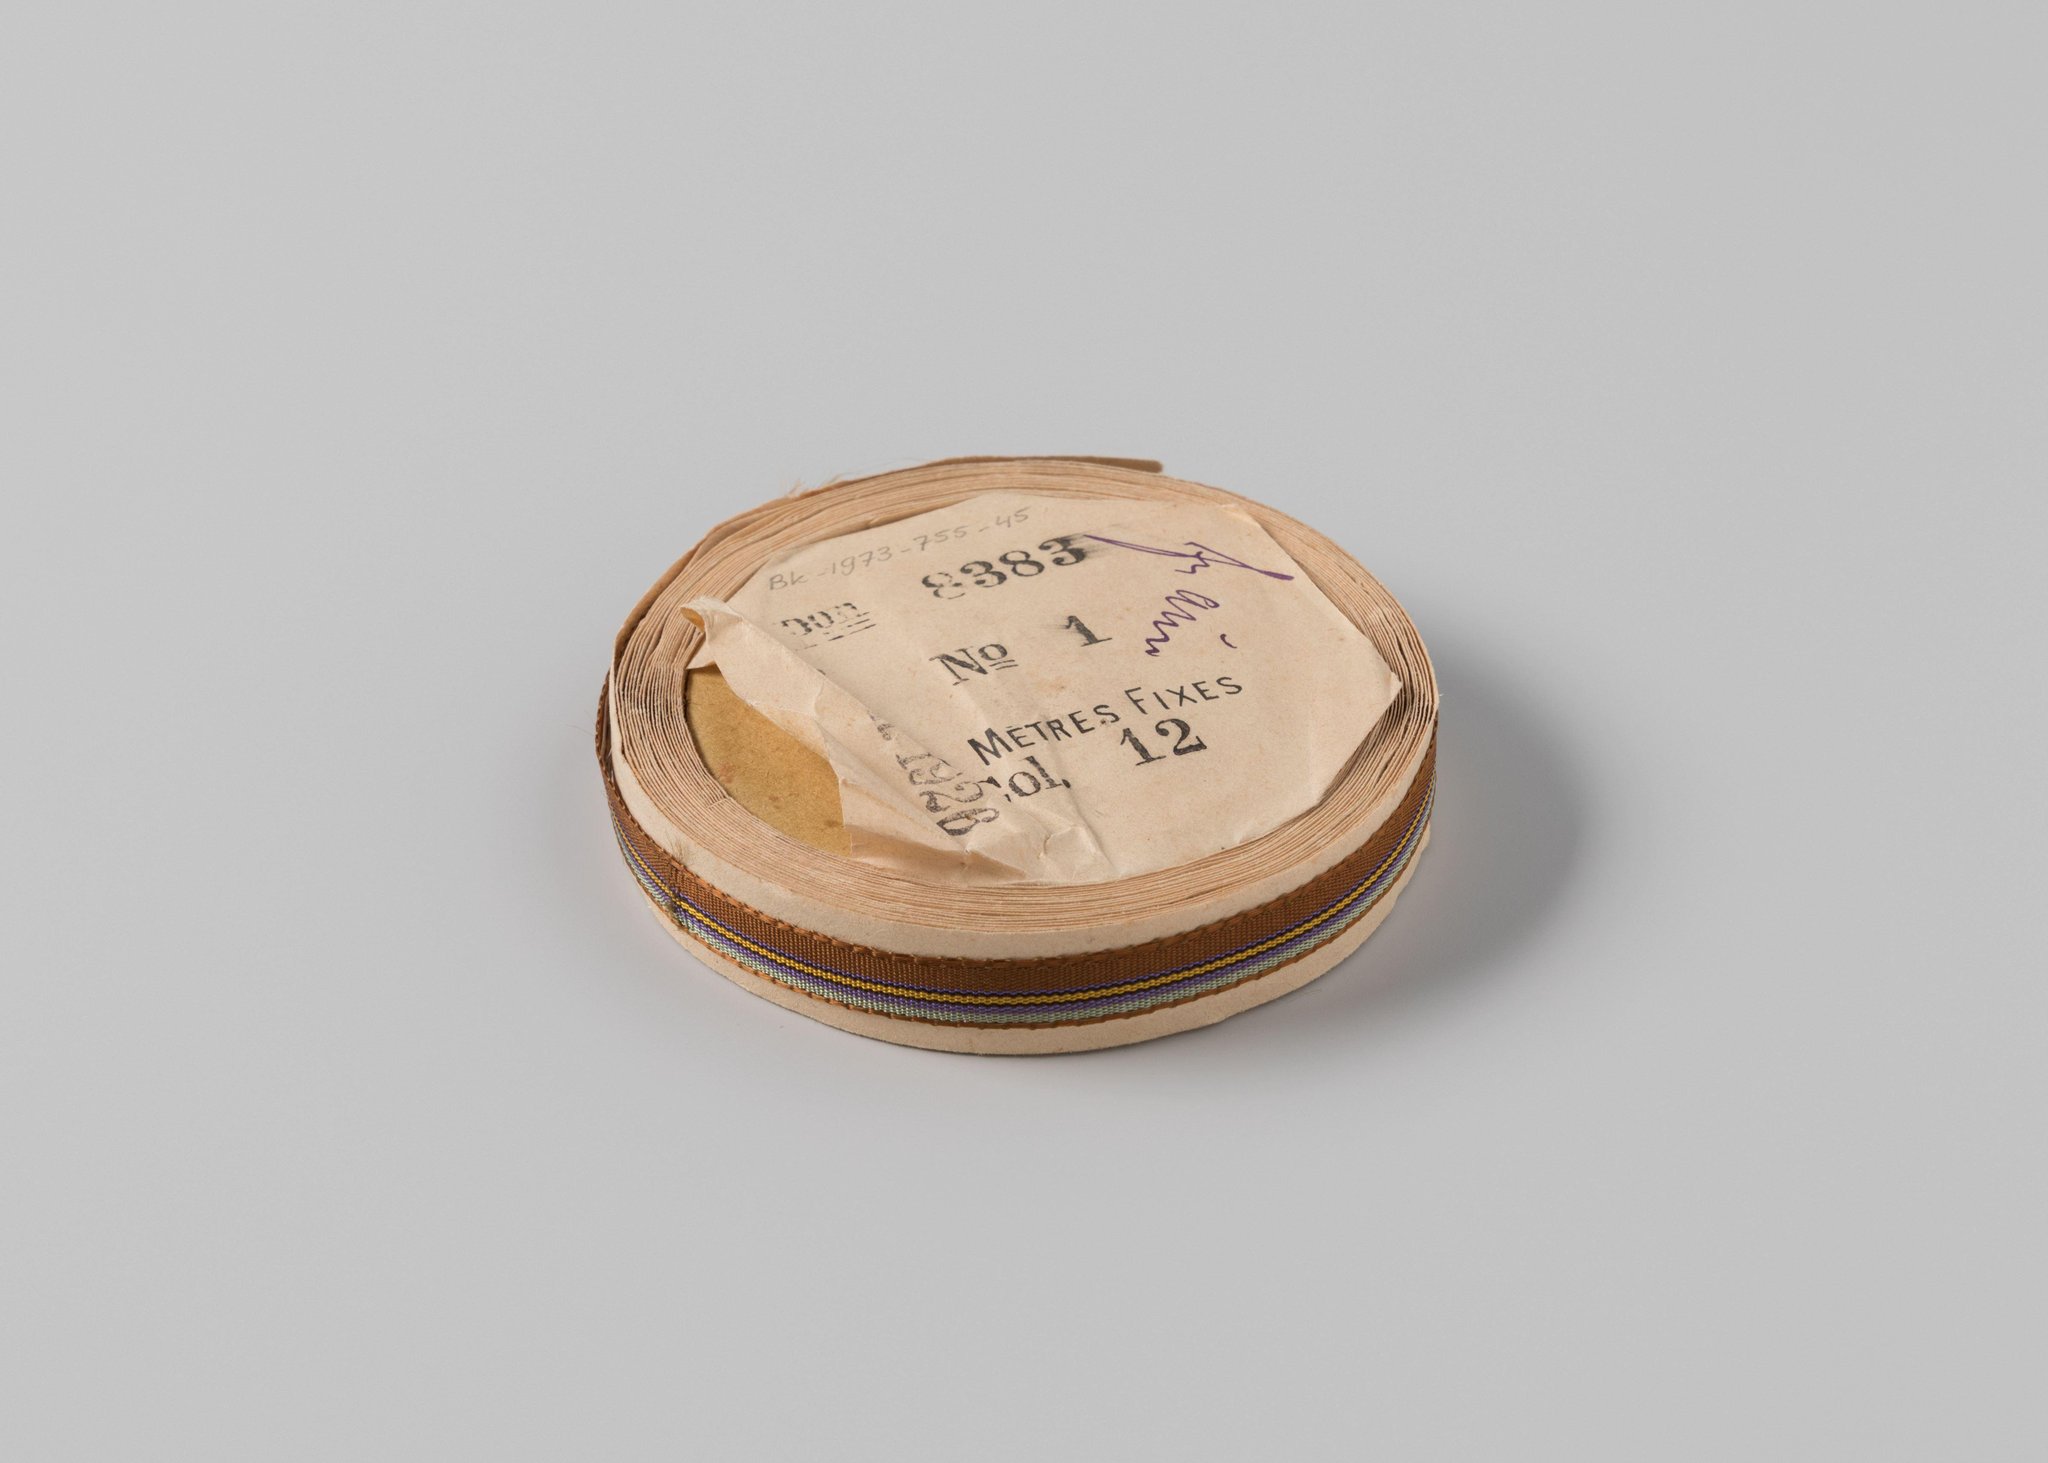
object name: ribbon material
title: Lint op rol, gestreept, bruin met lila, zwart, lichtgroen en oranje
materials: cardboard, paper, textile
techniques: weave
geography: nijmegen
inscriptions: stamp: ‘9 - APR. 1926’, number: ‘Pon 8383’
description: Lint op rol, gestreept, bruin met lila, zwart, lichtgroen en oranje.